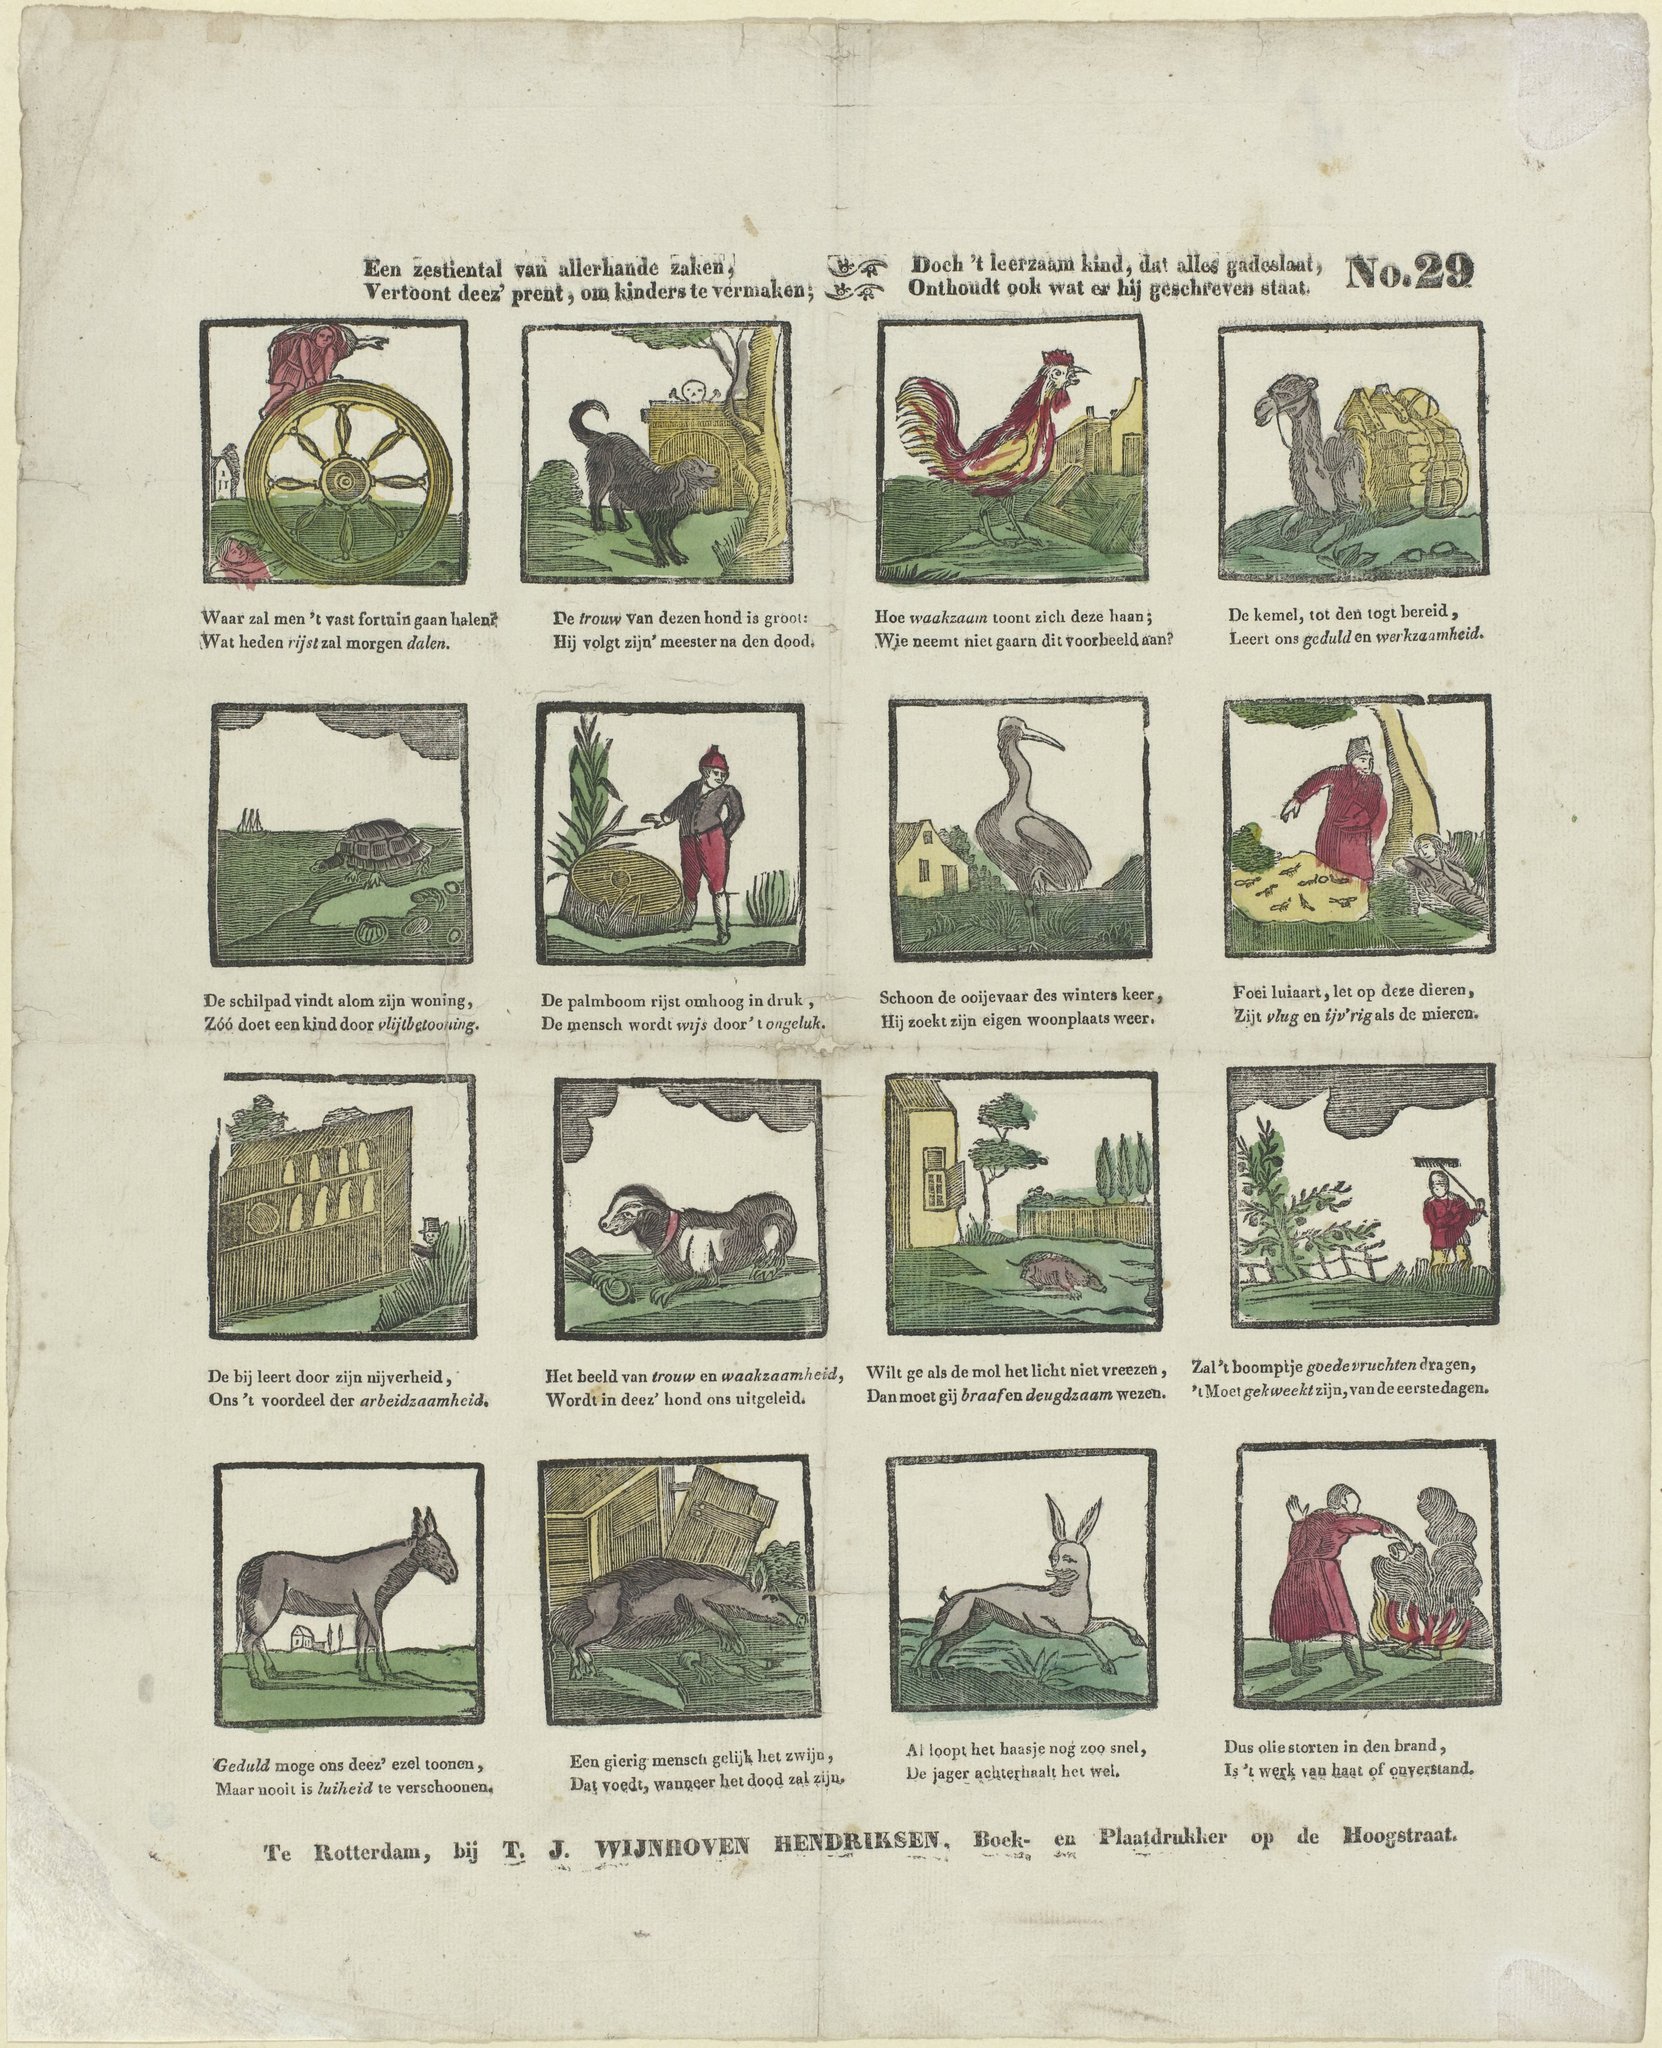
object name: print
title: Een zestiental van allerhande zaken, / Vertoont deez' prent, om kinders te vermaken; / Doch 't leerzaam kind, dat alles gadeslaat, / Onthoudt ook wat er bij geschreven staat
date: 1832-1850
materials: paper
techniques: colour, letterpress printing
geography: rotterdam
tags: animals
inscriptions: collector's mark: Lugt 2760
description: Blad met 16 voorstellingen van dieren en verschillende bezigheden, waaronder een waakzame haan, een trouwe hond en olie op het vuur gooien. Onder elke afbeelding een tweeregelig vers. Genummerd rechtsboven: No. 29.